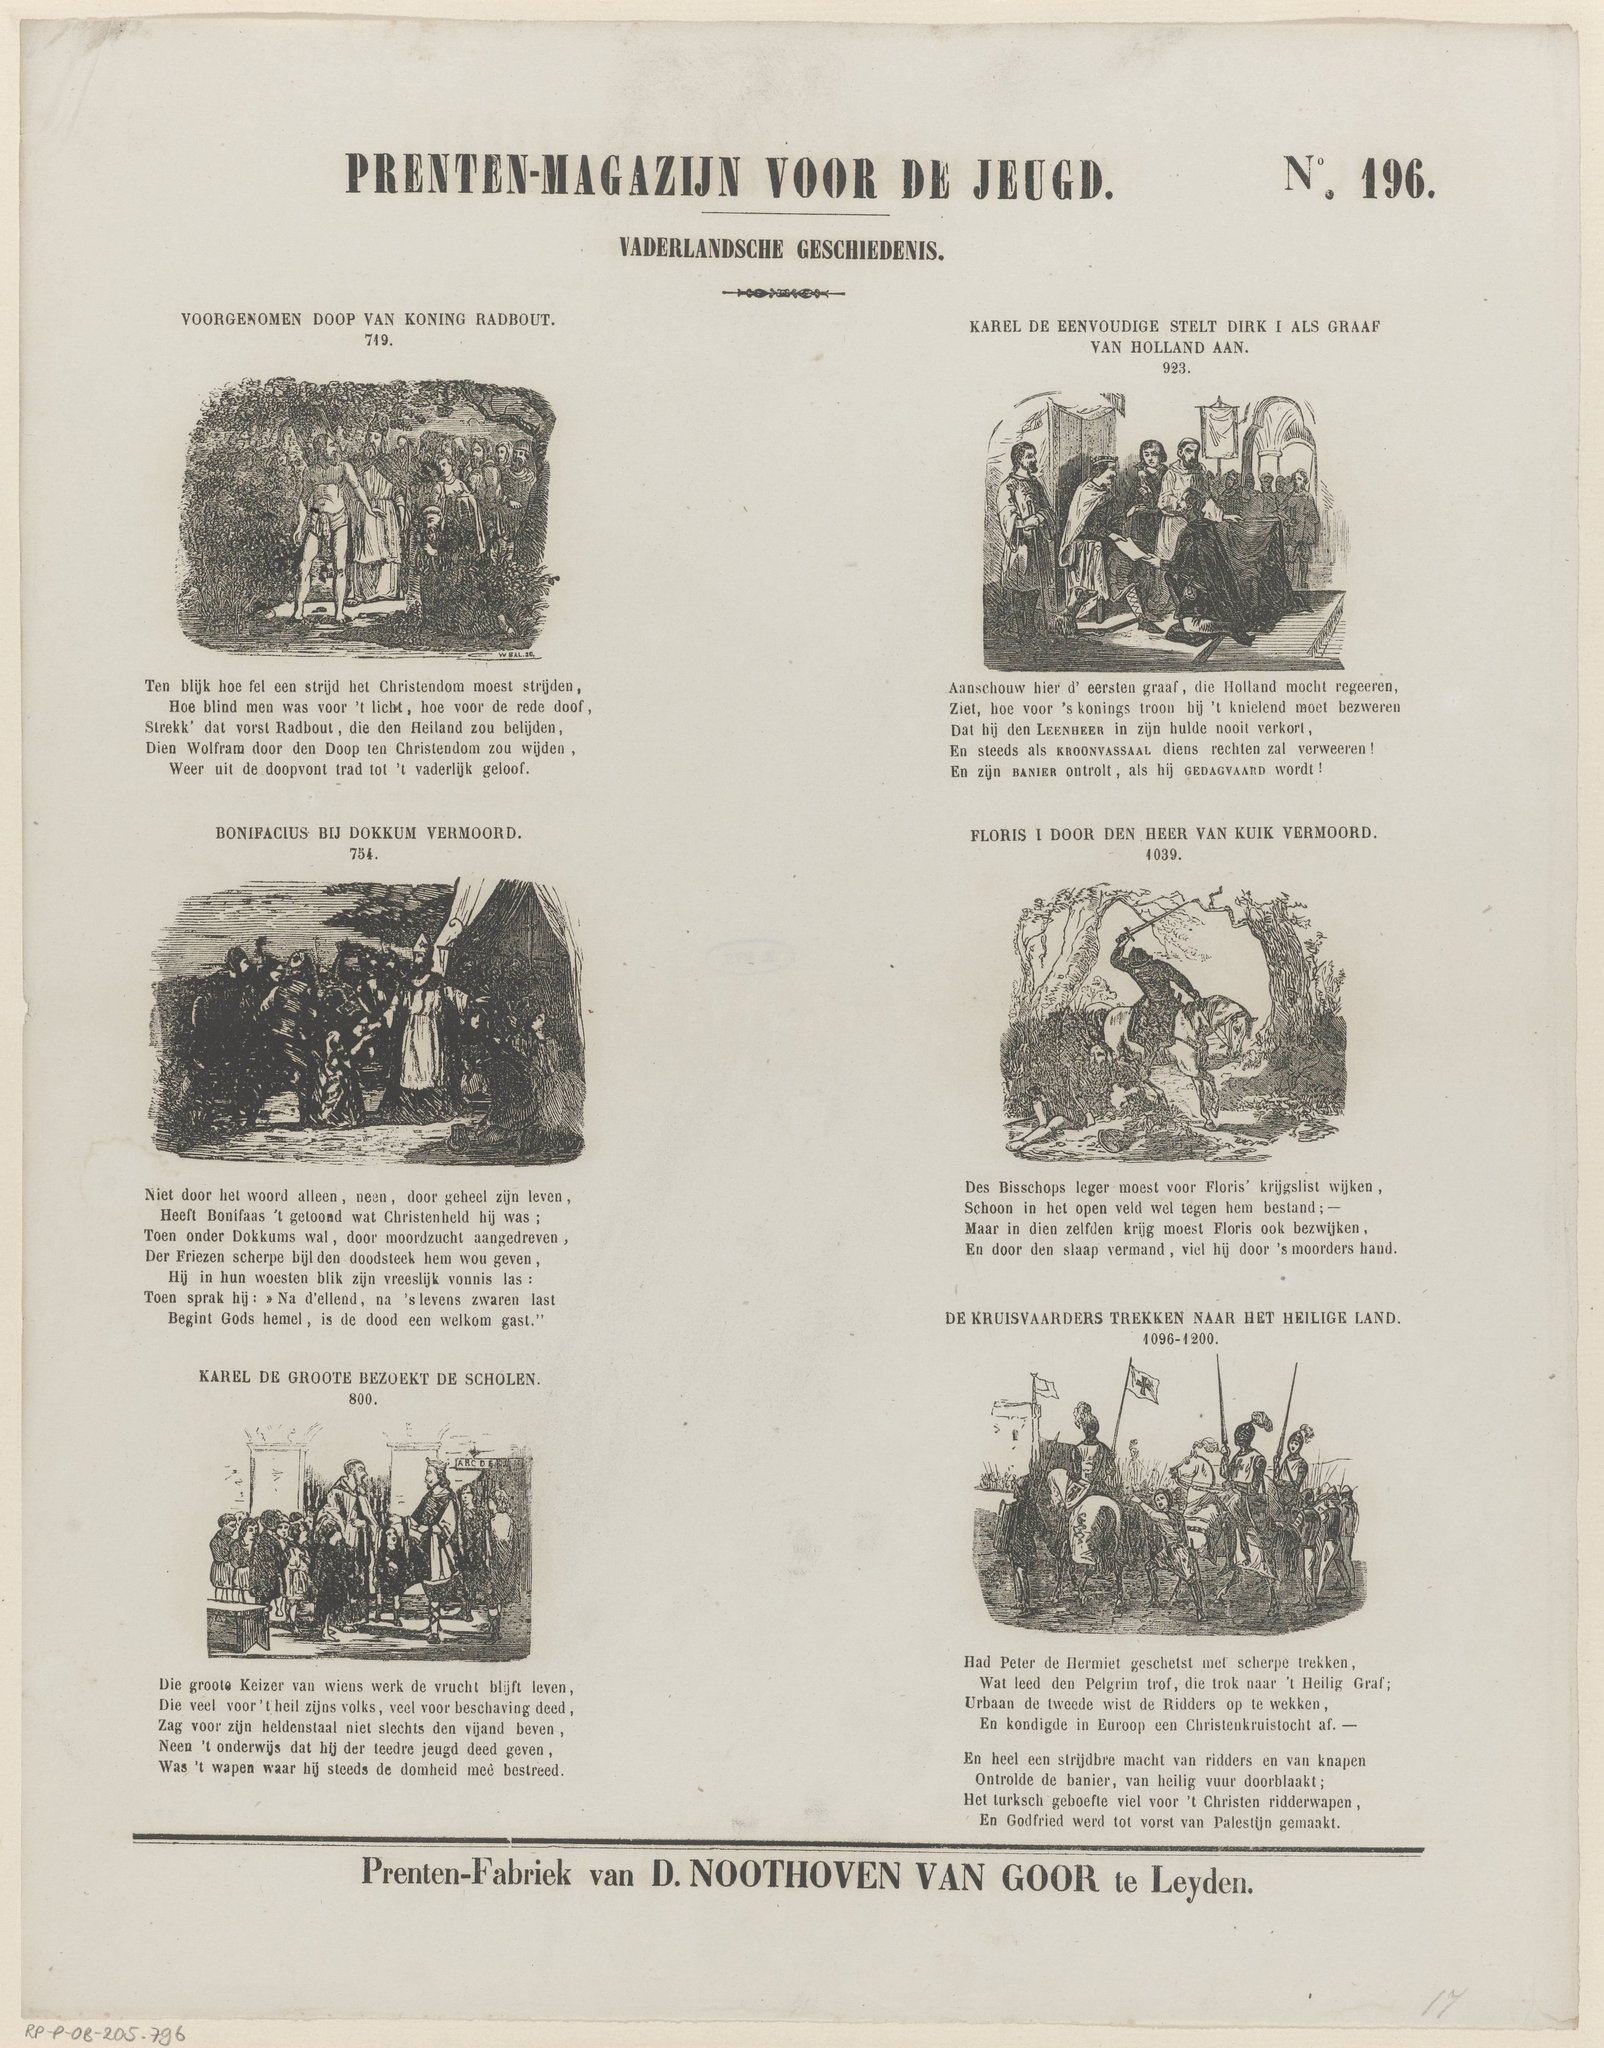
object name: print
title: Prenten-magazijn voor de jeugd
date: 1850-1881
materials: paper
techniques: letterpress printing, engraving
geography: leiden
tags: charlemagne (holy roman emperor), bishop st. eloi preaching, martyr(s) (often with palm-branches)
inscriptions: collector's mark: Lugt 2228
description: Blad met 6 voorstellingen van gebeurtenissen uit de vaderlandse geschiedenis, met betrekking tot het Christendom. Boven elke voorstelling een titel en een jaartal, onder elke voorstelling een vierregelig vers. Genummerd rechtsboven: No. 196.